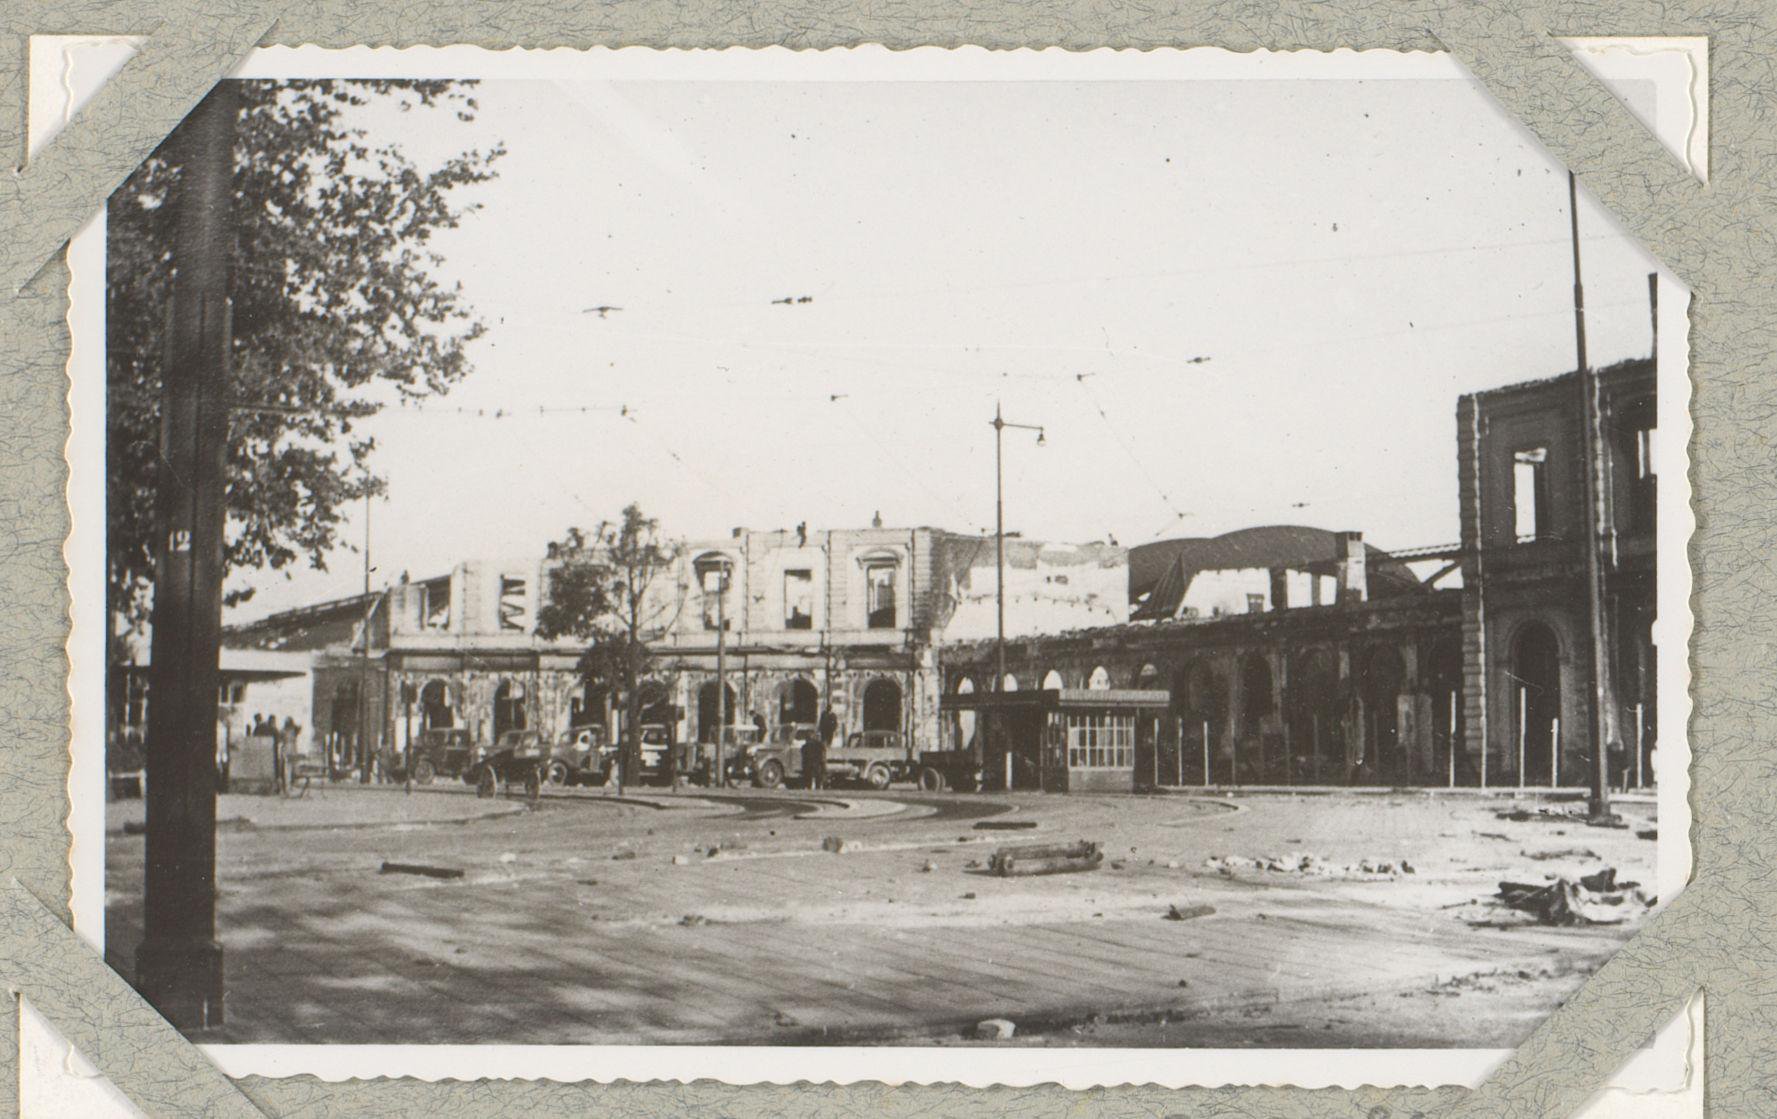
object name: photograph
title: Ruïne van het station te Rotterdam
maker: j. nolte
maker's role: fotograaf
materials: photographic support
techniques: gelatin silver print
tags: devastated, ruined place or city (~ warfare), station; shelter (railway, tramway), ruin of a dwelling, house, castle, etc., rotterdam, rotterdam blitz